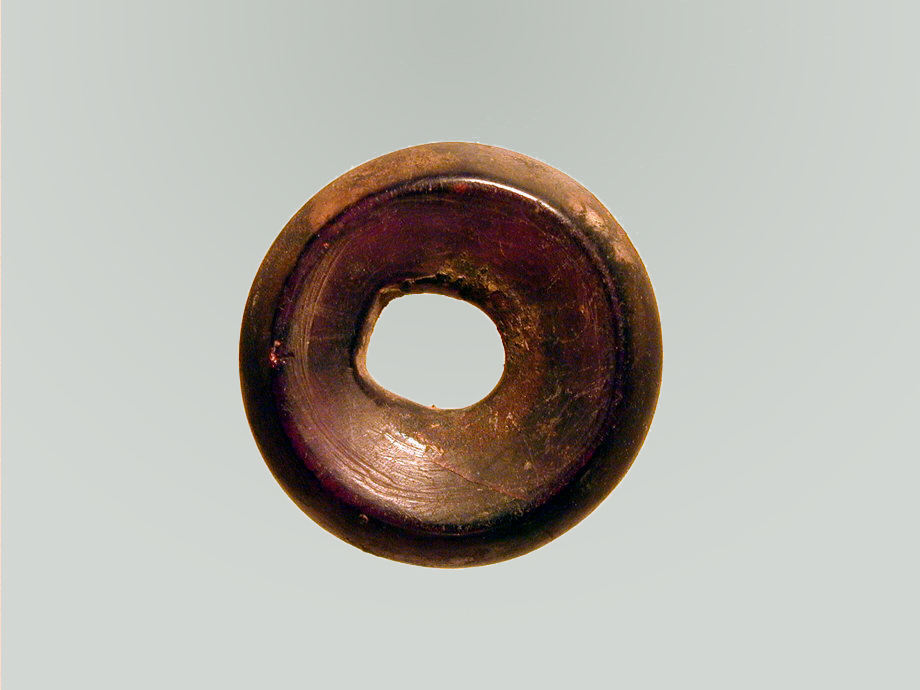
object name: whorl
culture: etruscan or italic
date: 700-601 BCE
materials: amber